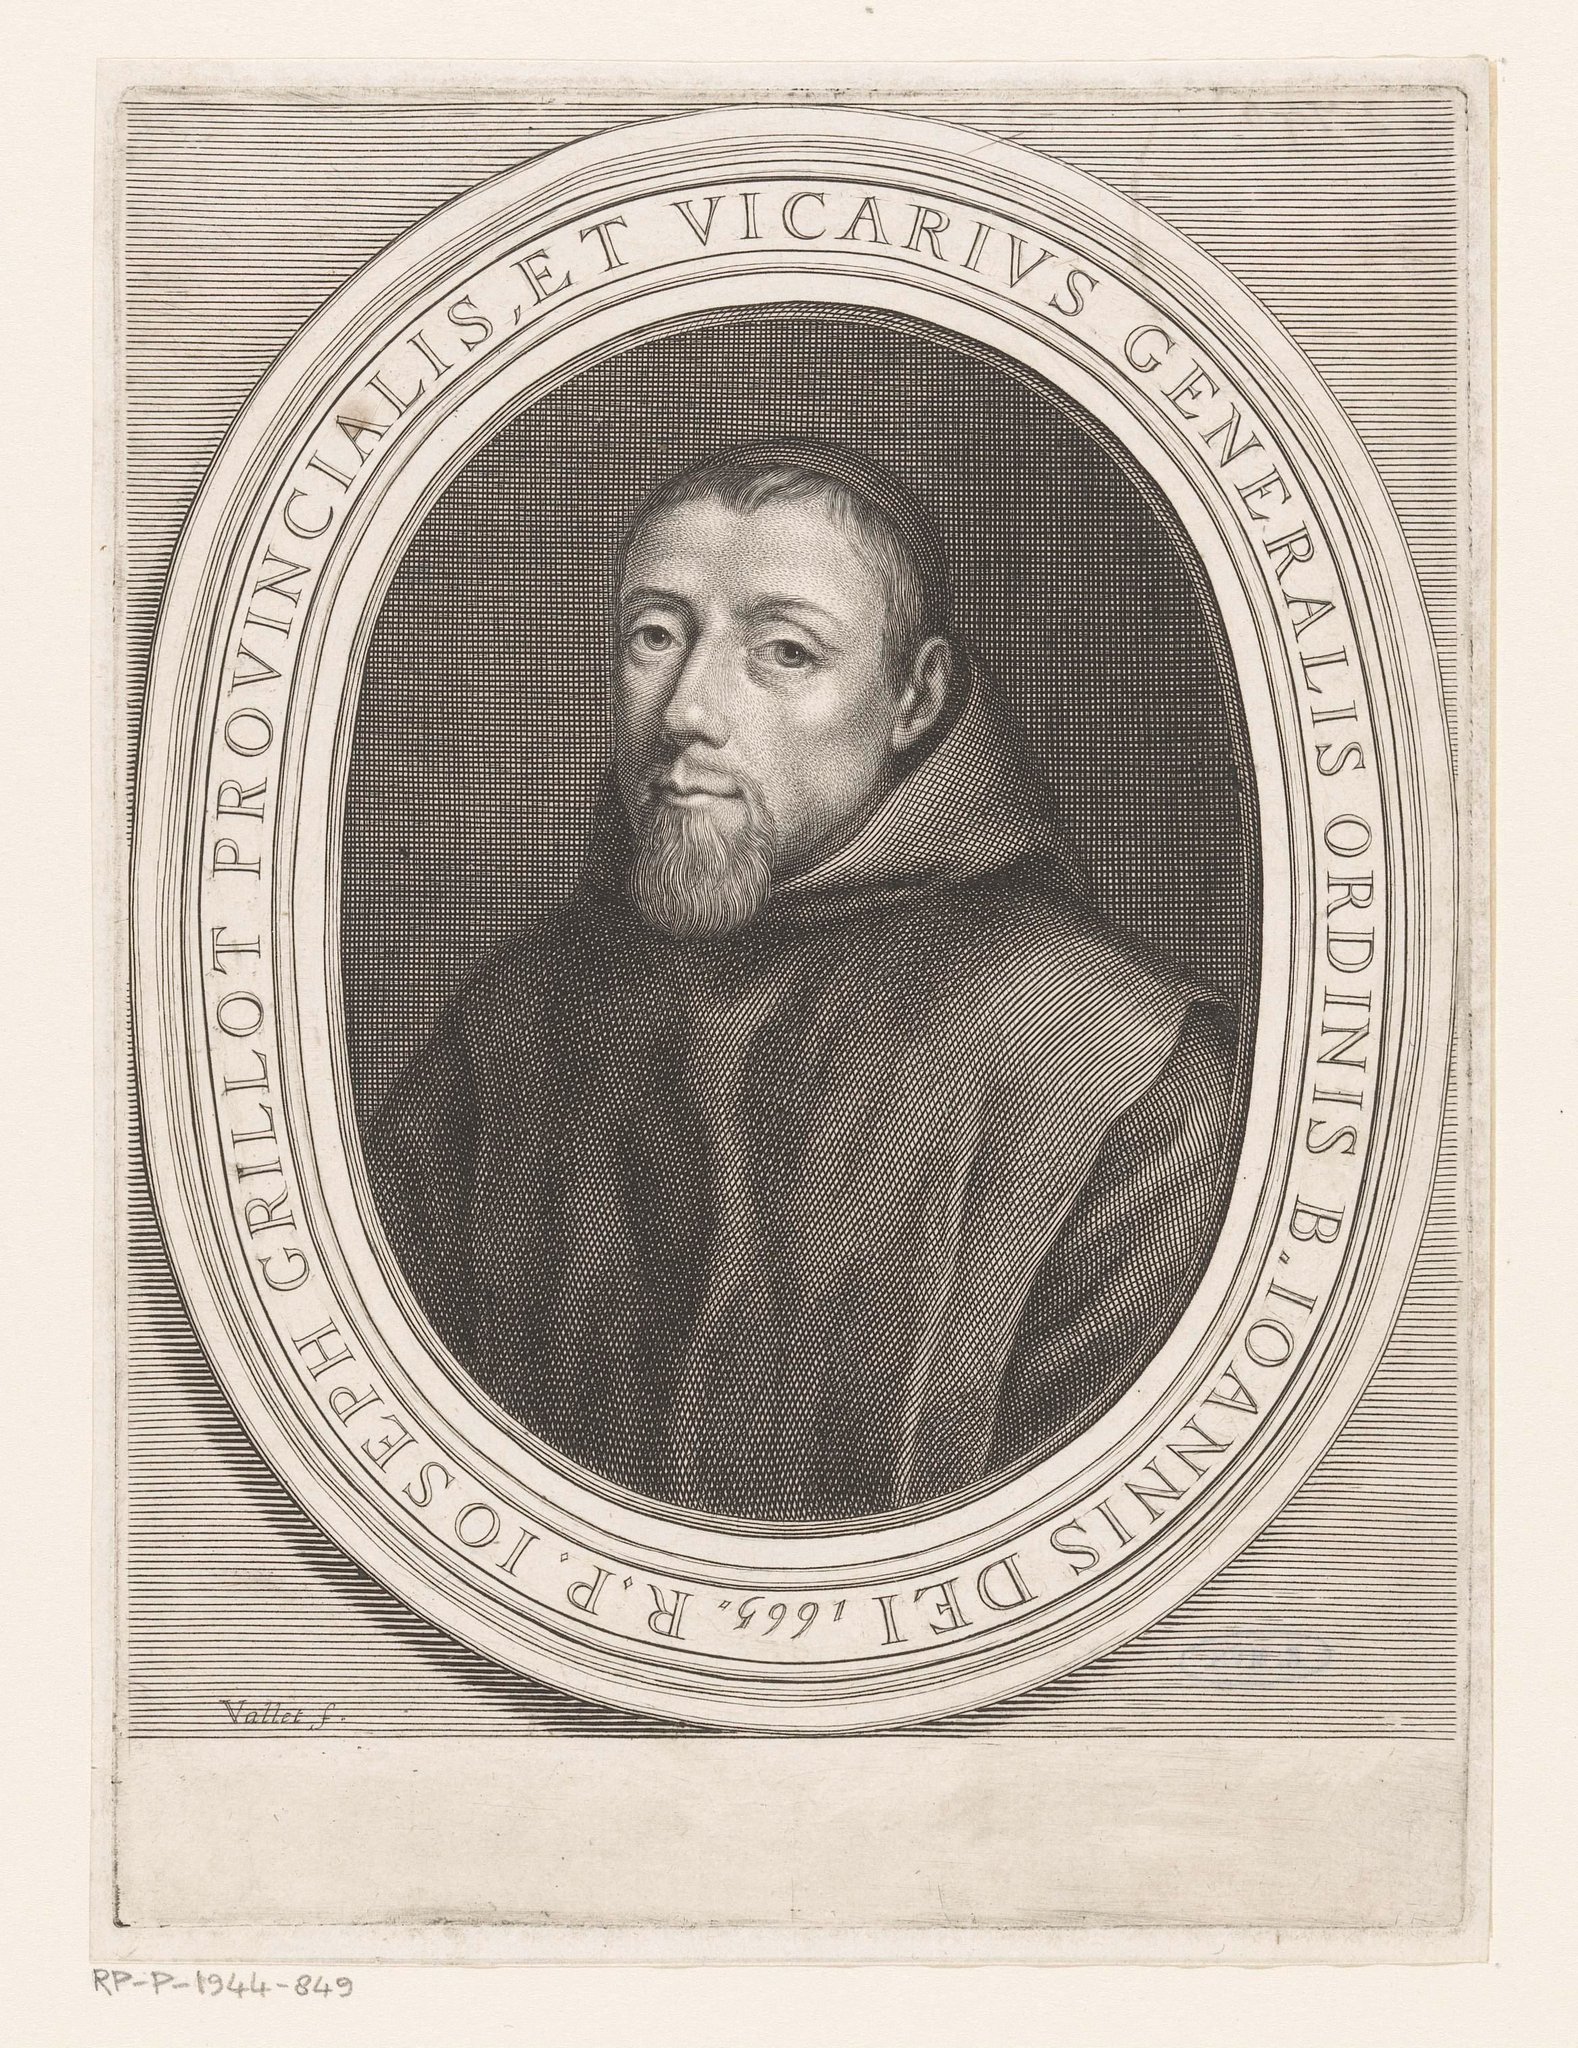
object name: print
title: Portret van Joseph Grillot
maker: guillaume vallet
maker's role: print maker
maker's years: 1632-1704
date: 1665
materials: paper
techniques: engraving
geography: paris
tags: historical persons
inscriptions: collector's mark: Lugt 2228, number: ‘2746’